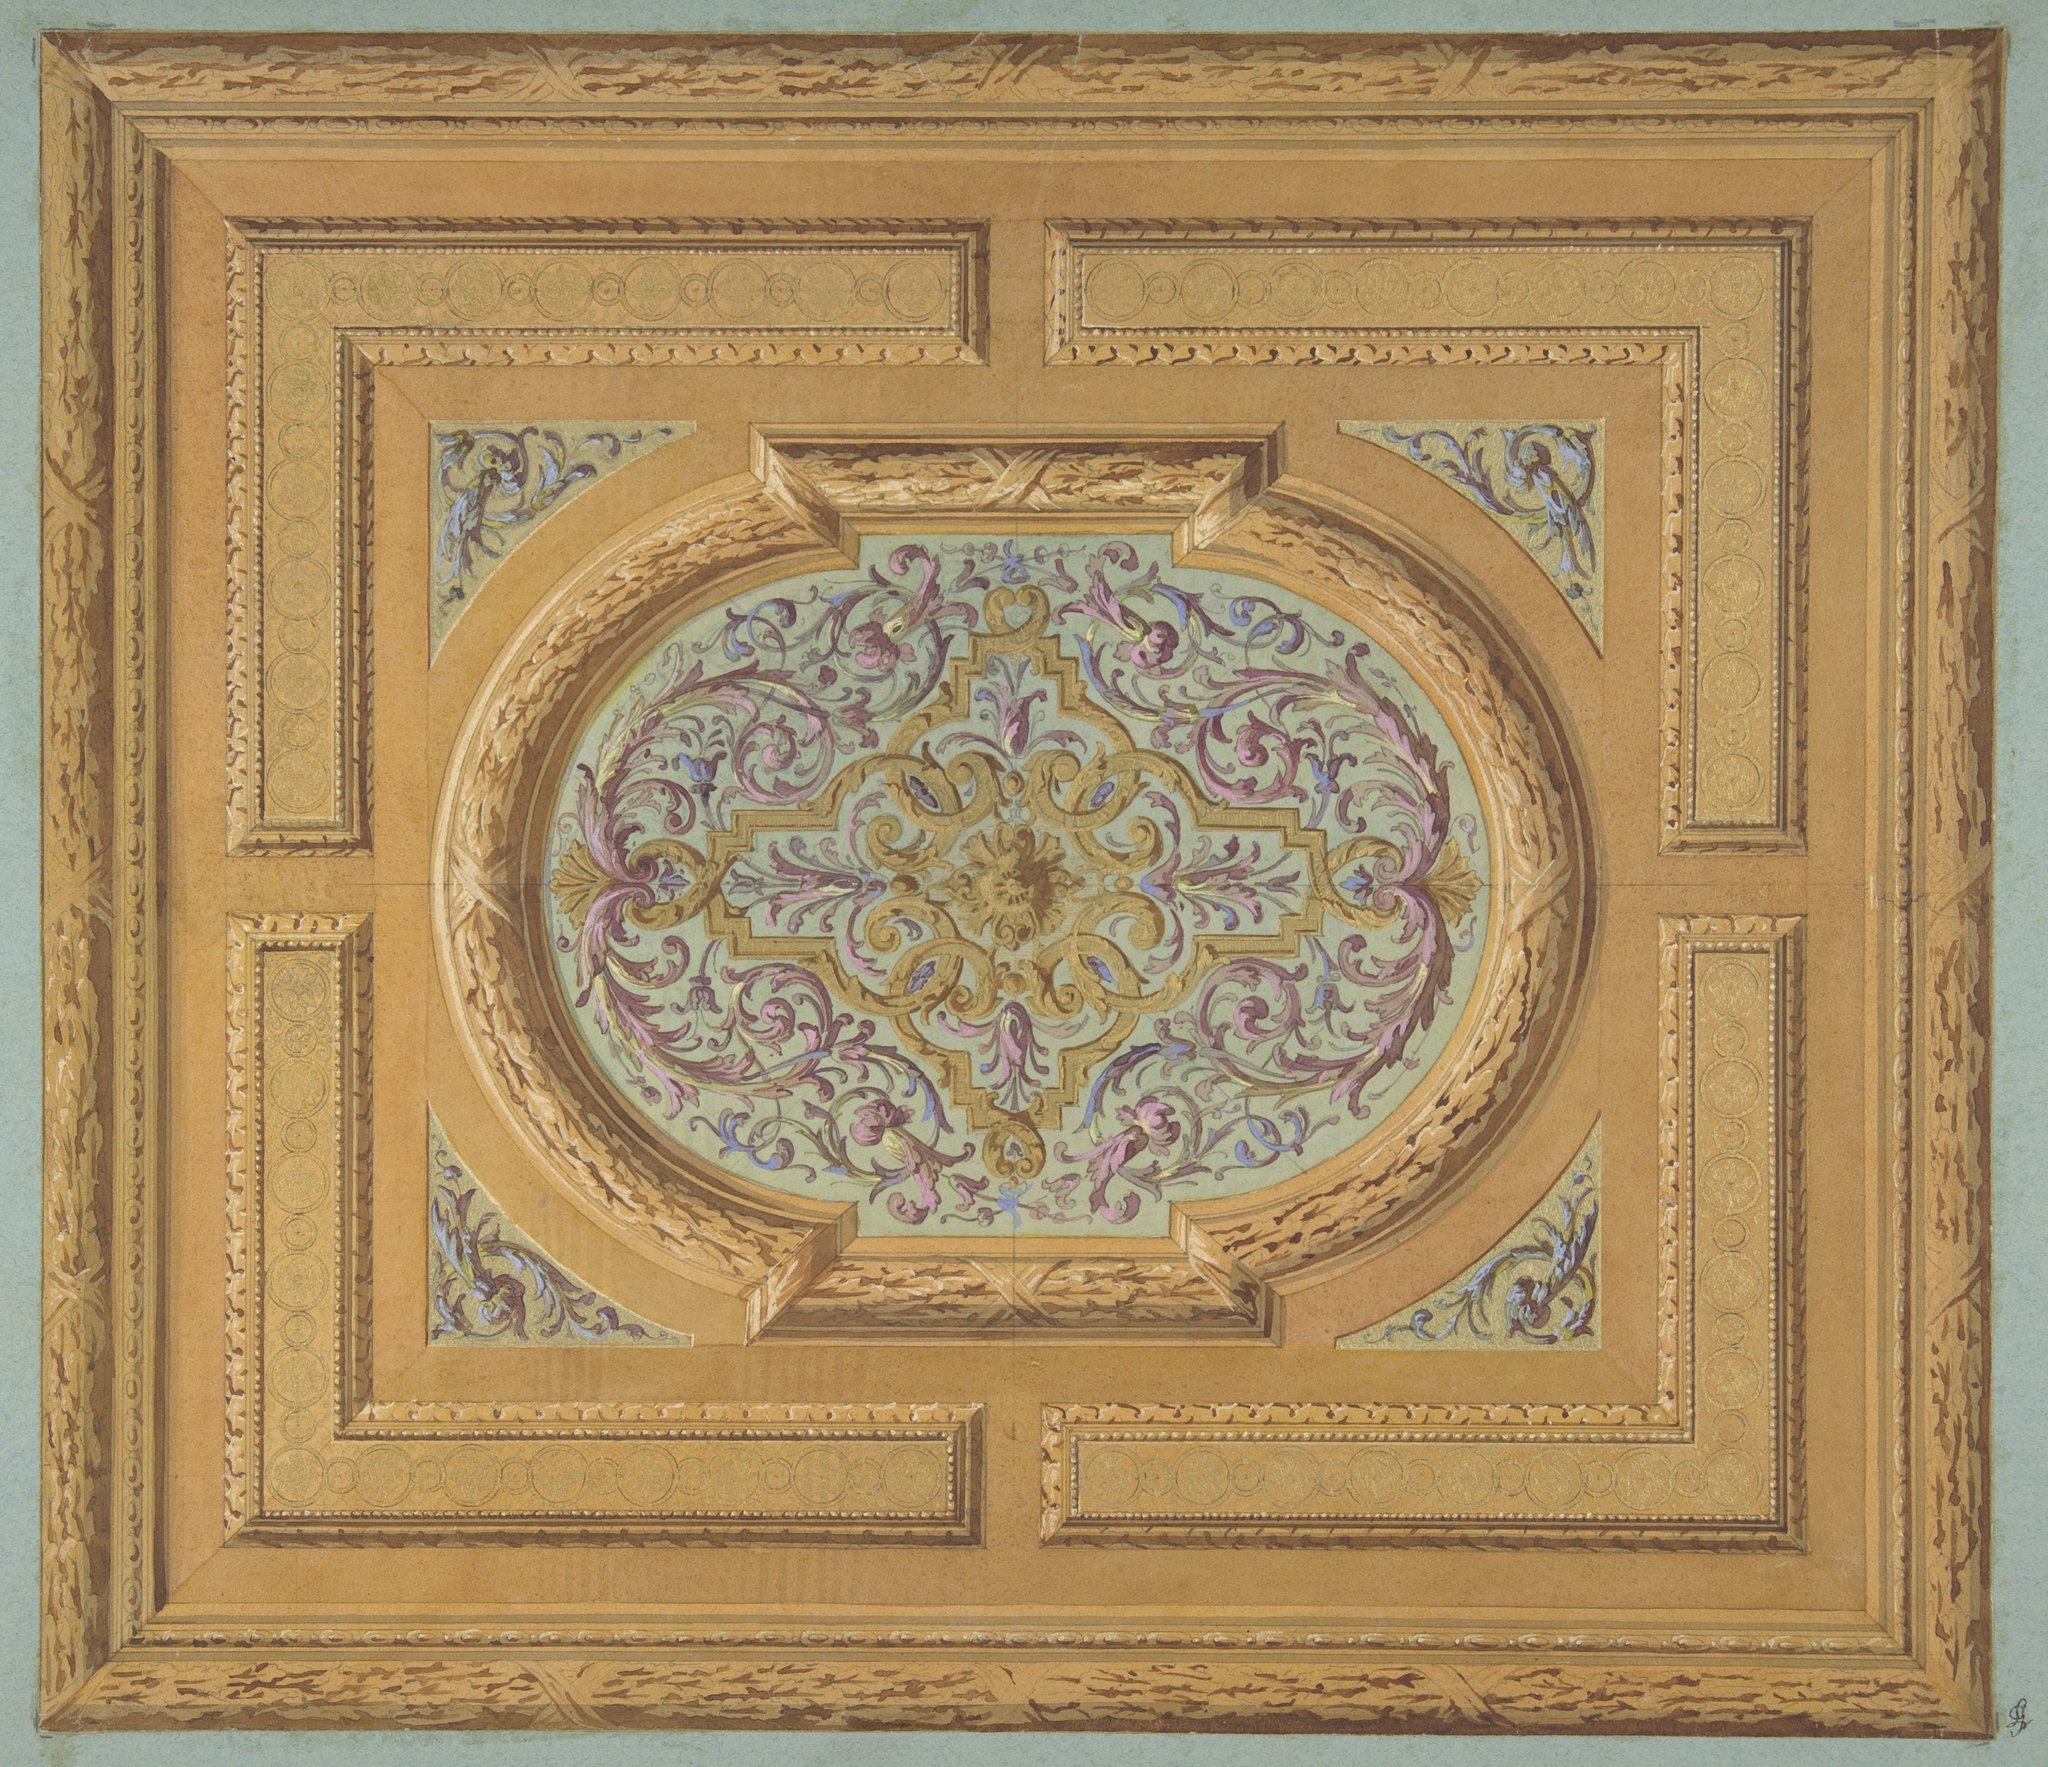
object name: drawing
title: Design for a ceiling decorated with bands of oak leaves and a central panel of scrolls and rinceaux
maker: jules-edmond-charles lachaise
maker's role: artist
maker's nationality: french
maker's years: 1897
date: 1830-1897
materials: gold paint, gouache, graphite, watercolor, paper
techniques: inlay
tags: leaves